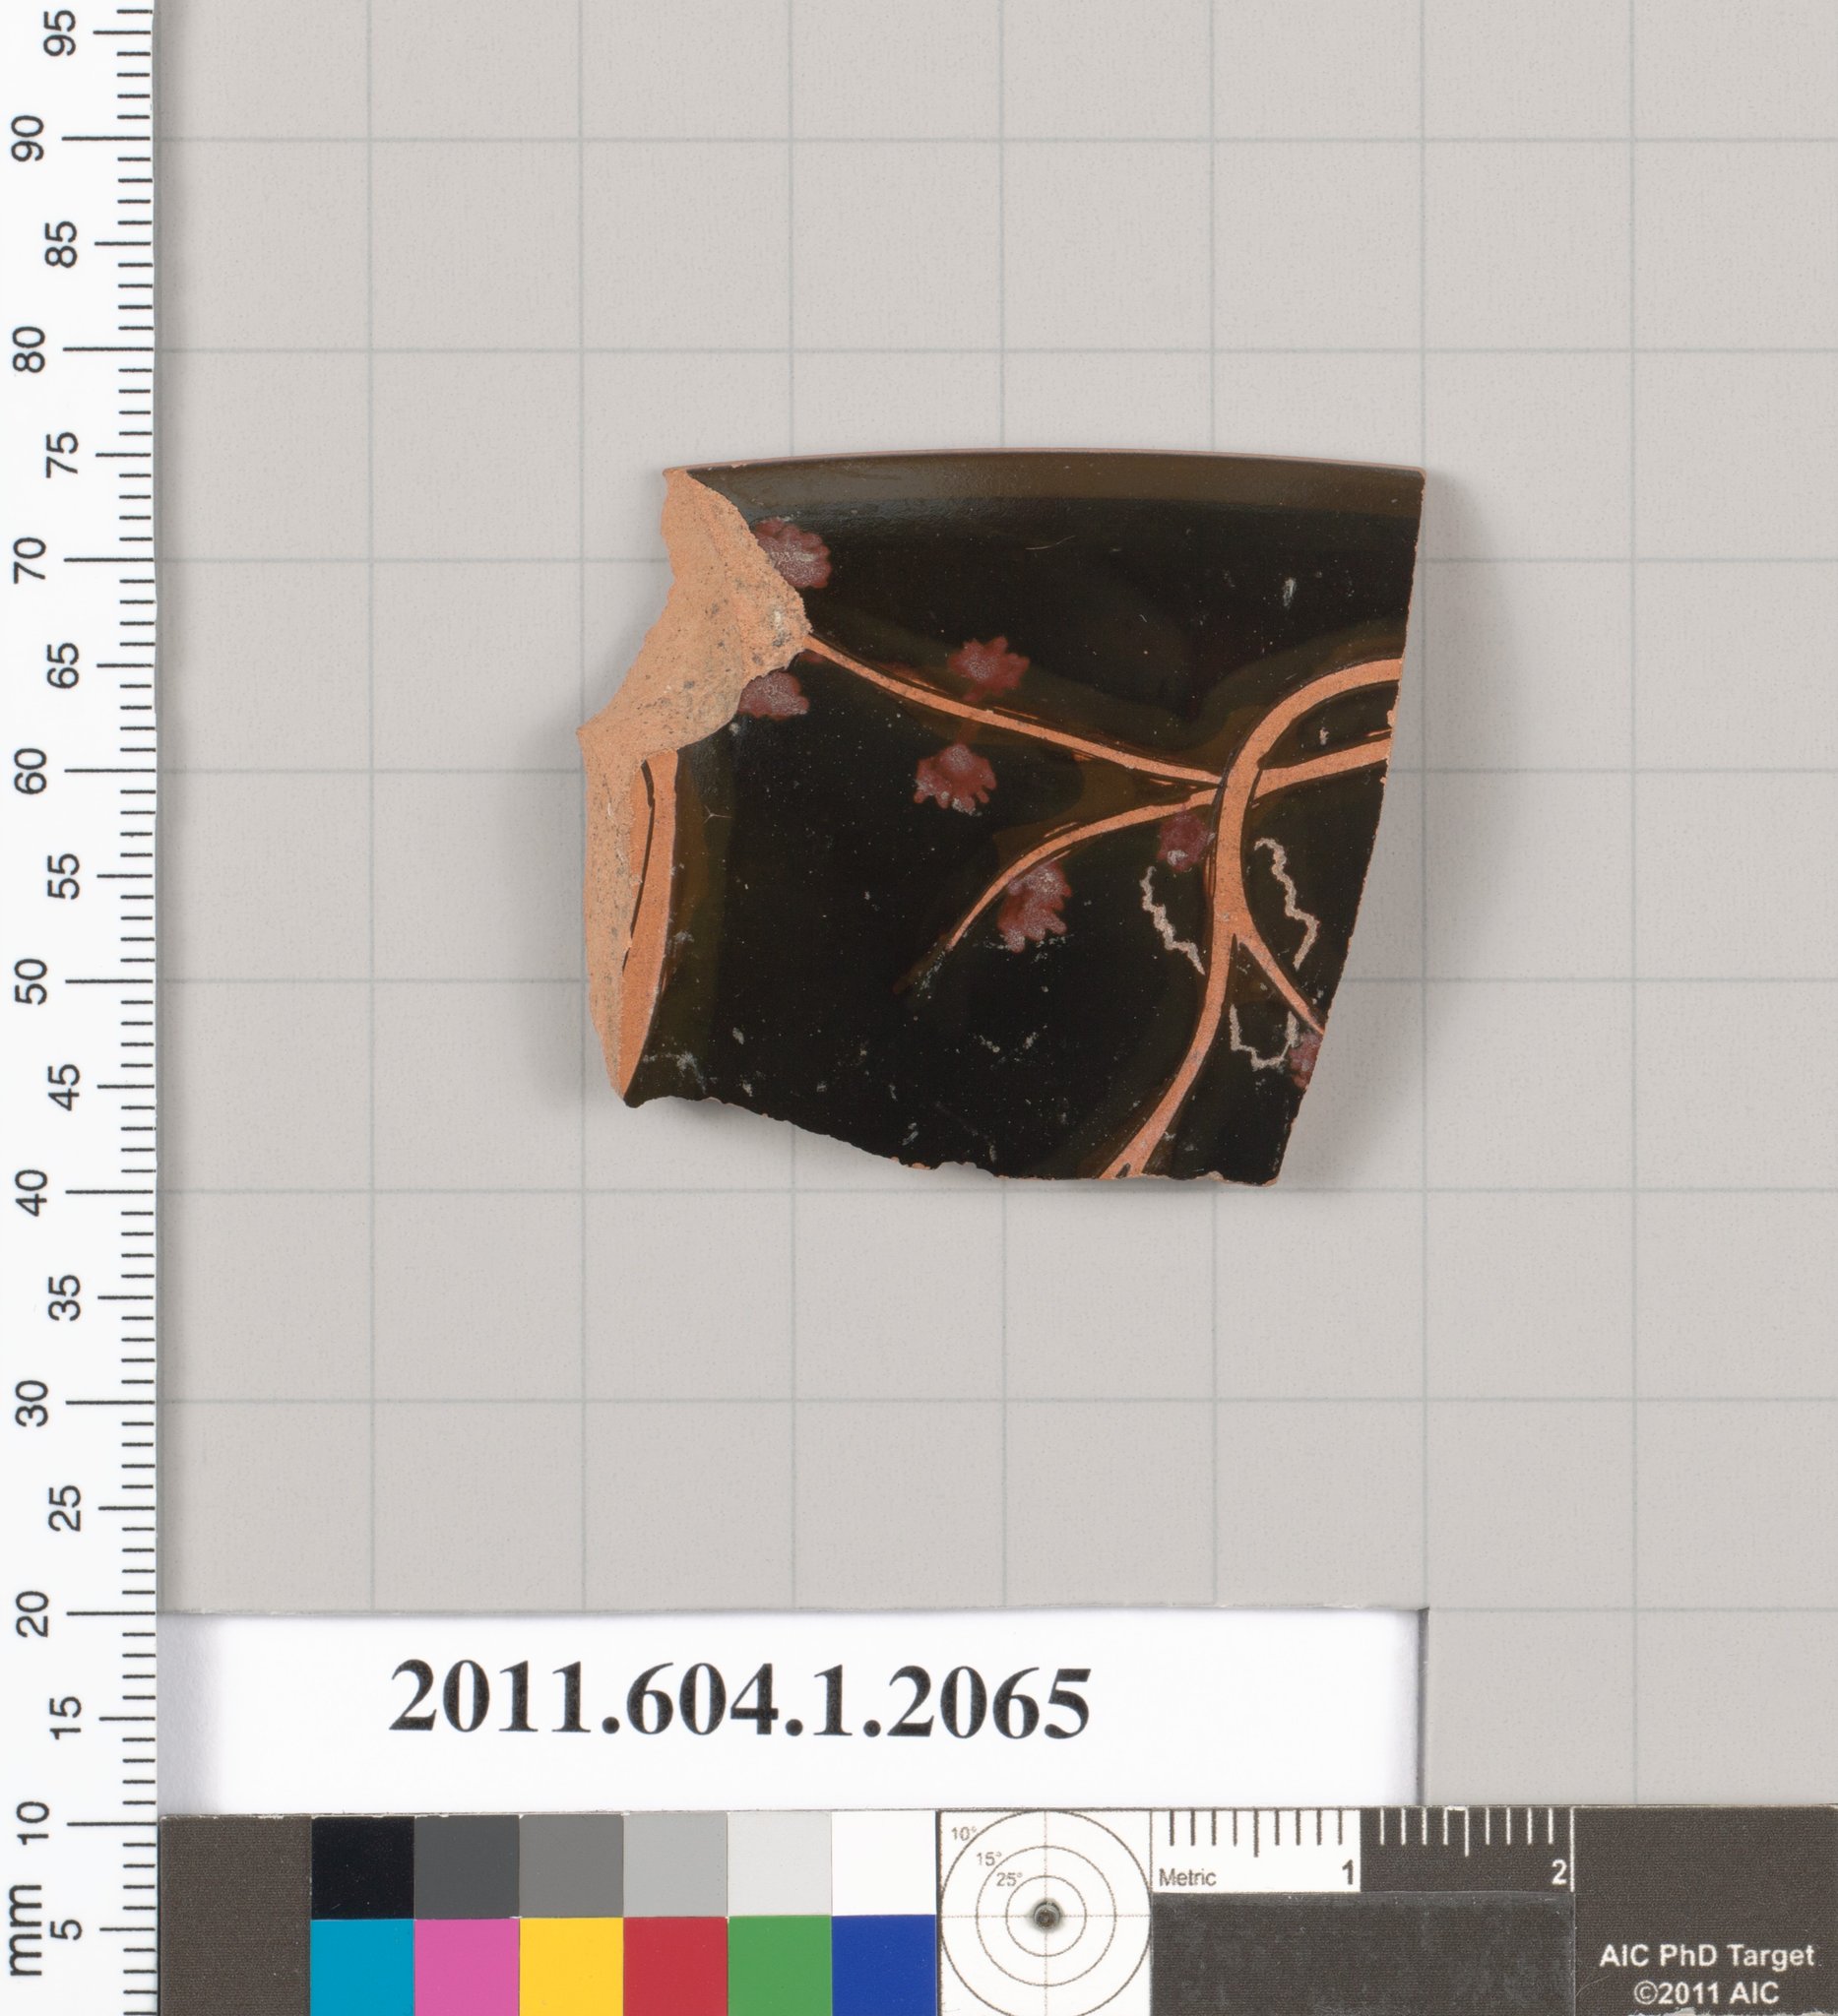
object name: kylix fragment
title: Terracotta rim fragment of a kylix (drinking cup)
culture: greek, attic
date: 490-480 BCE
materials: terracotta